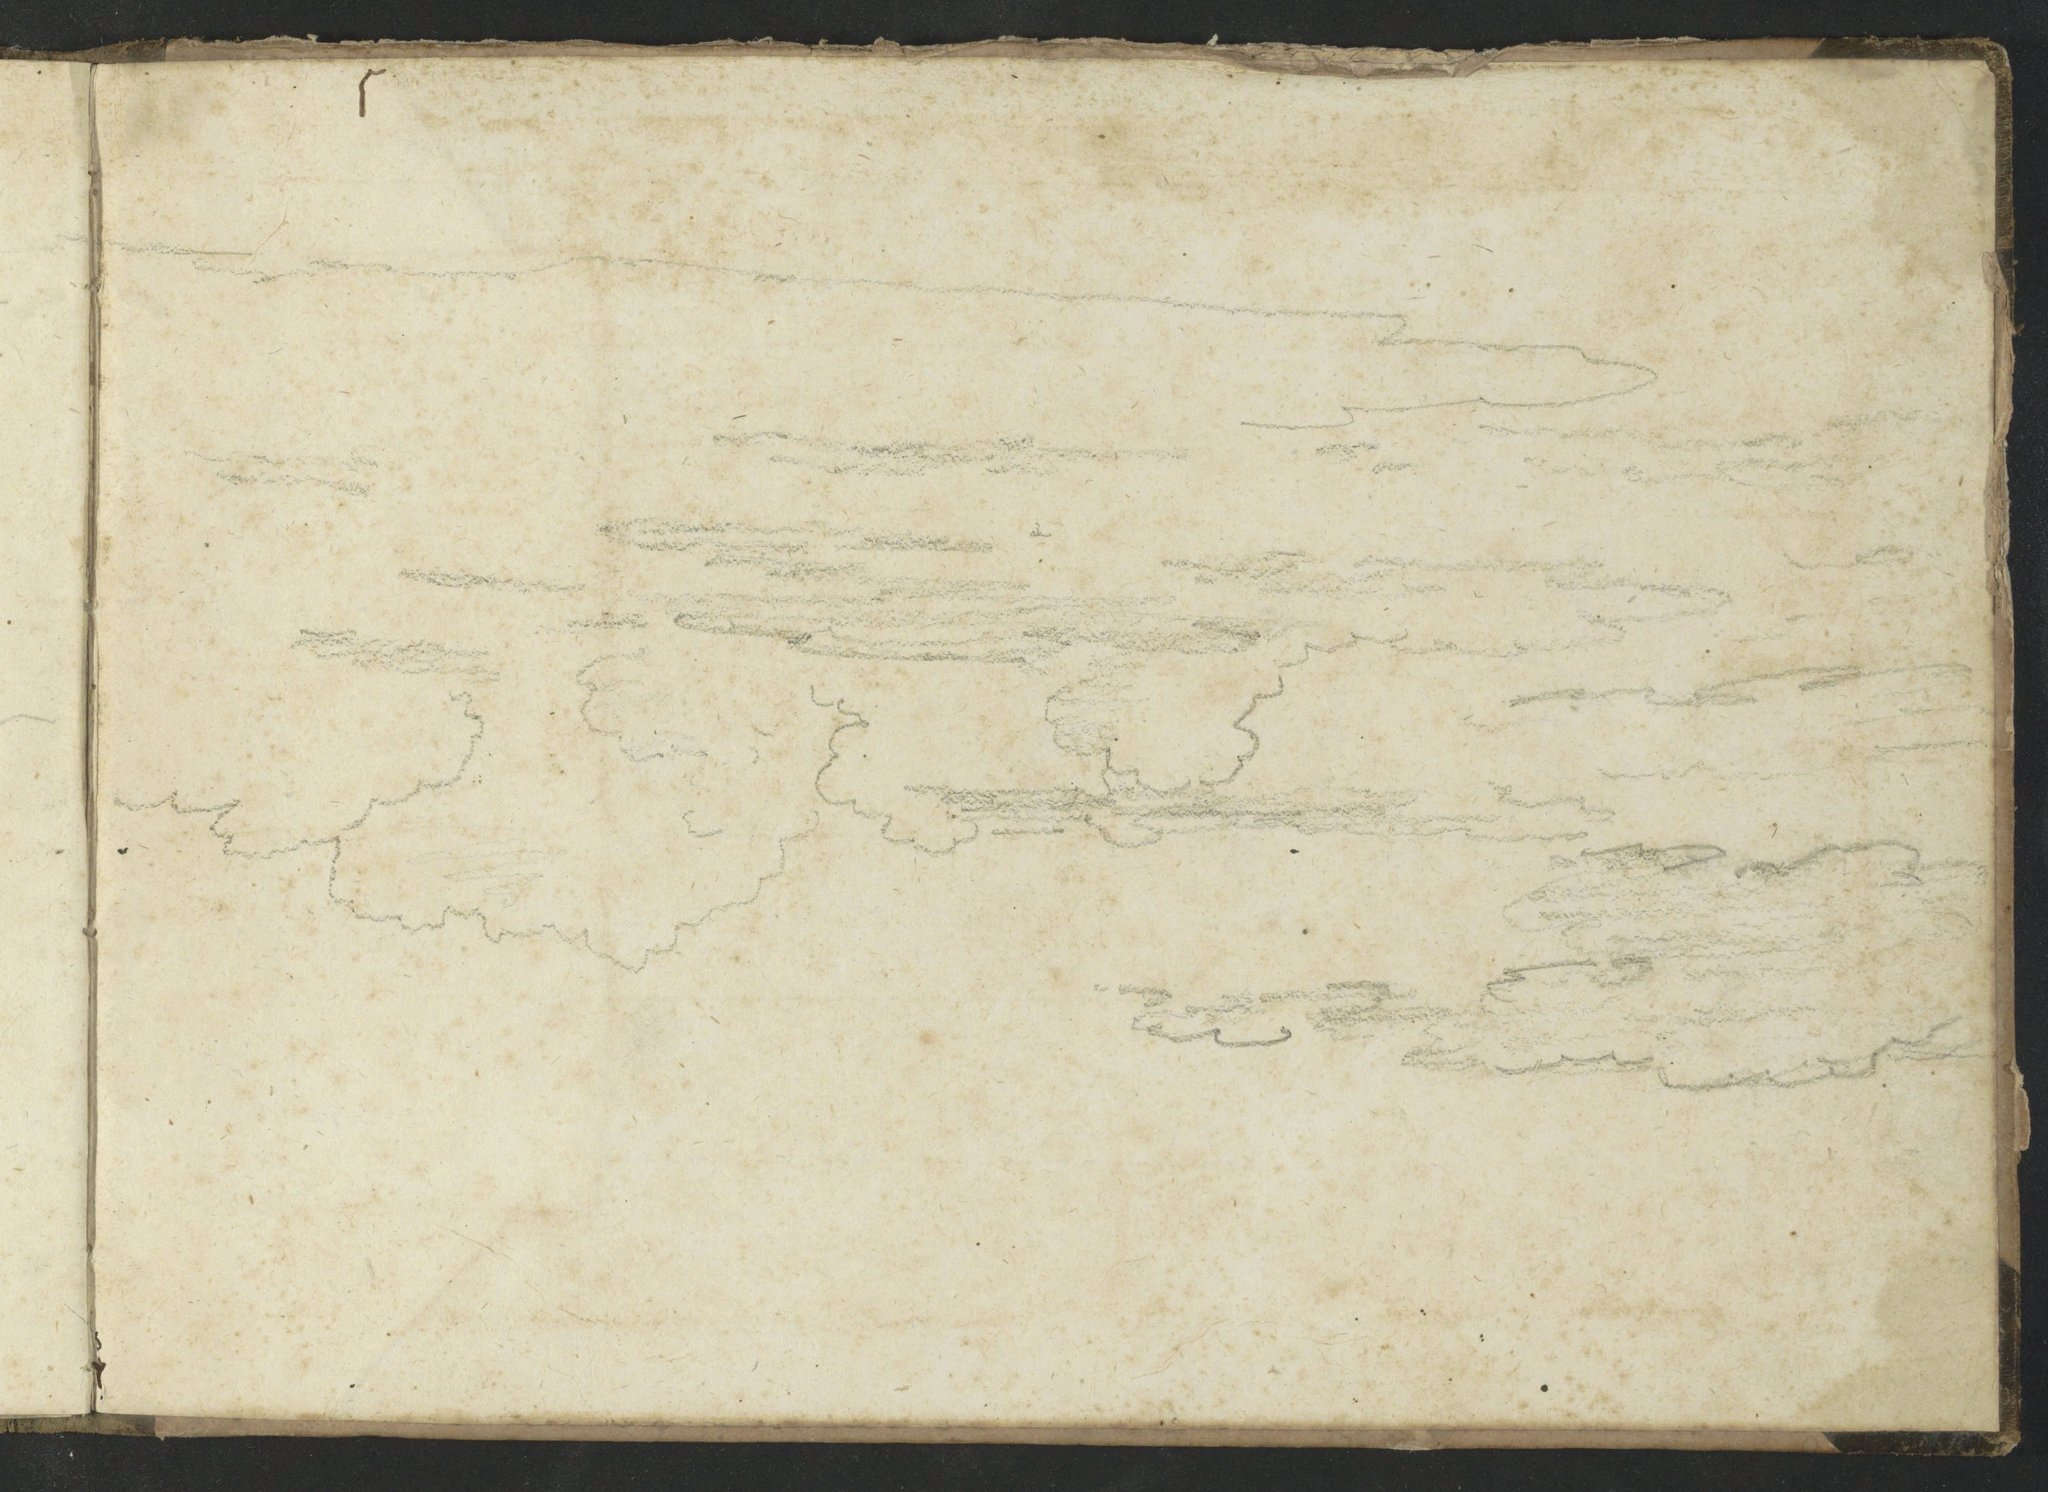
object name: endleaf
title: Wolken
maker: abraham teerlink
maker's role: draughtsman, painter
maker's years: 1776-1857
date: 1808-1857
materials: paper, pencil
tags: clouds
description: Achterste schutblad uit een schetsboek met 28 bladen.